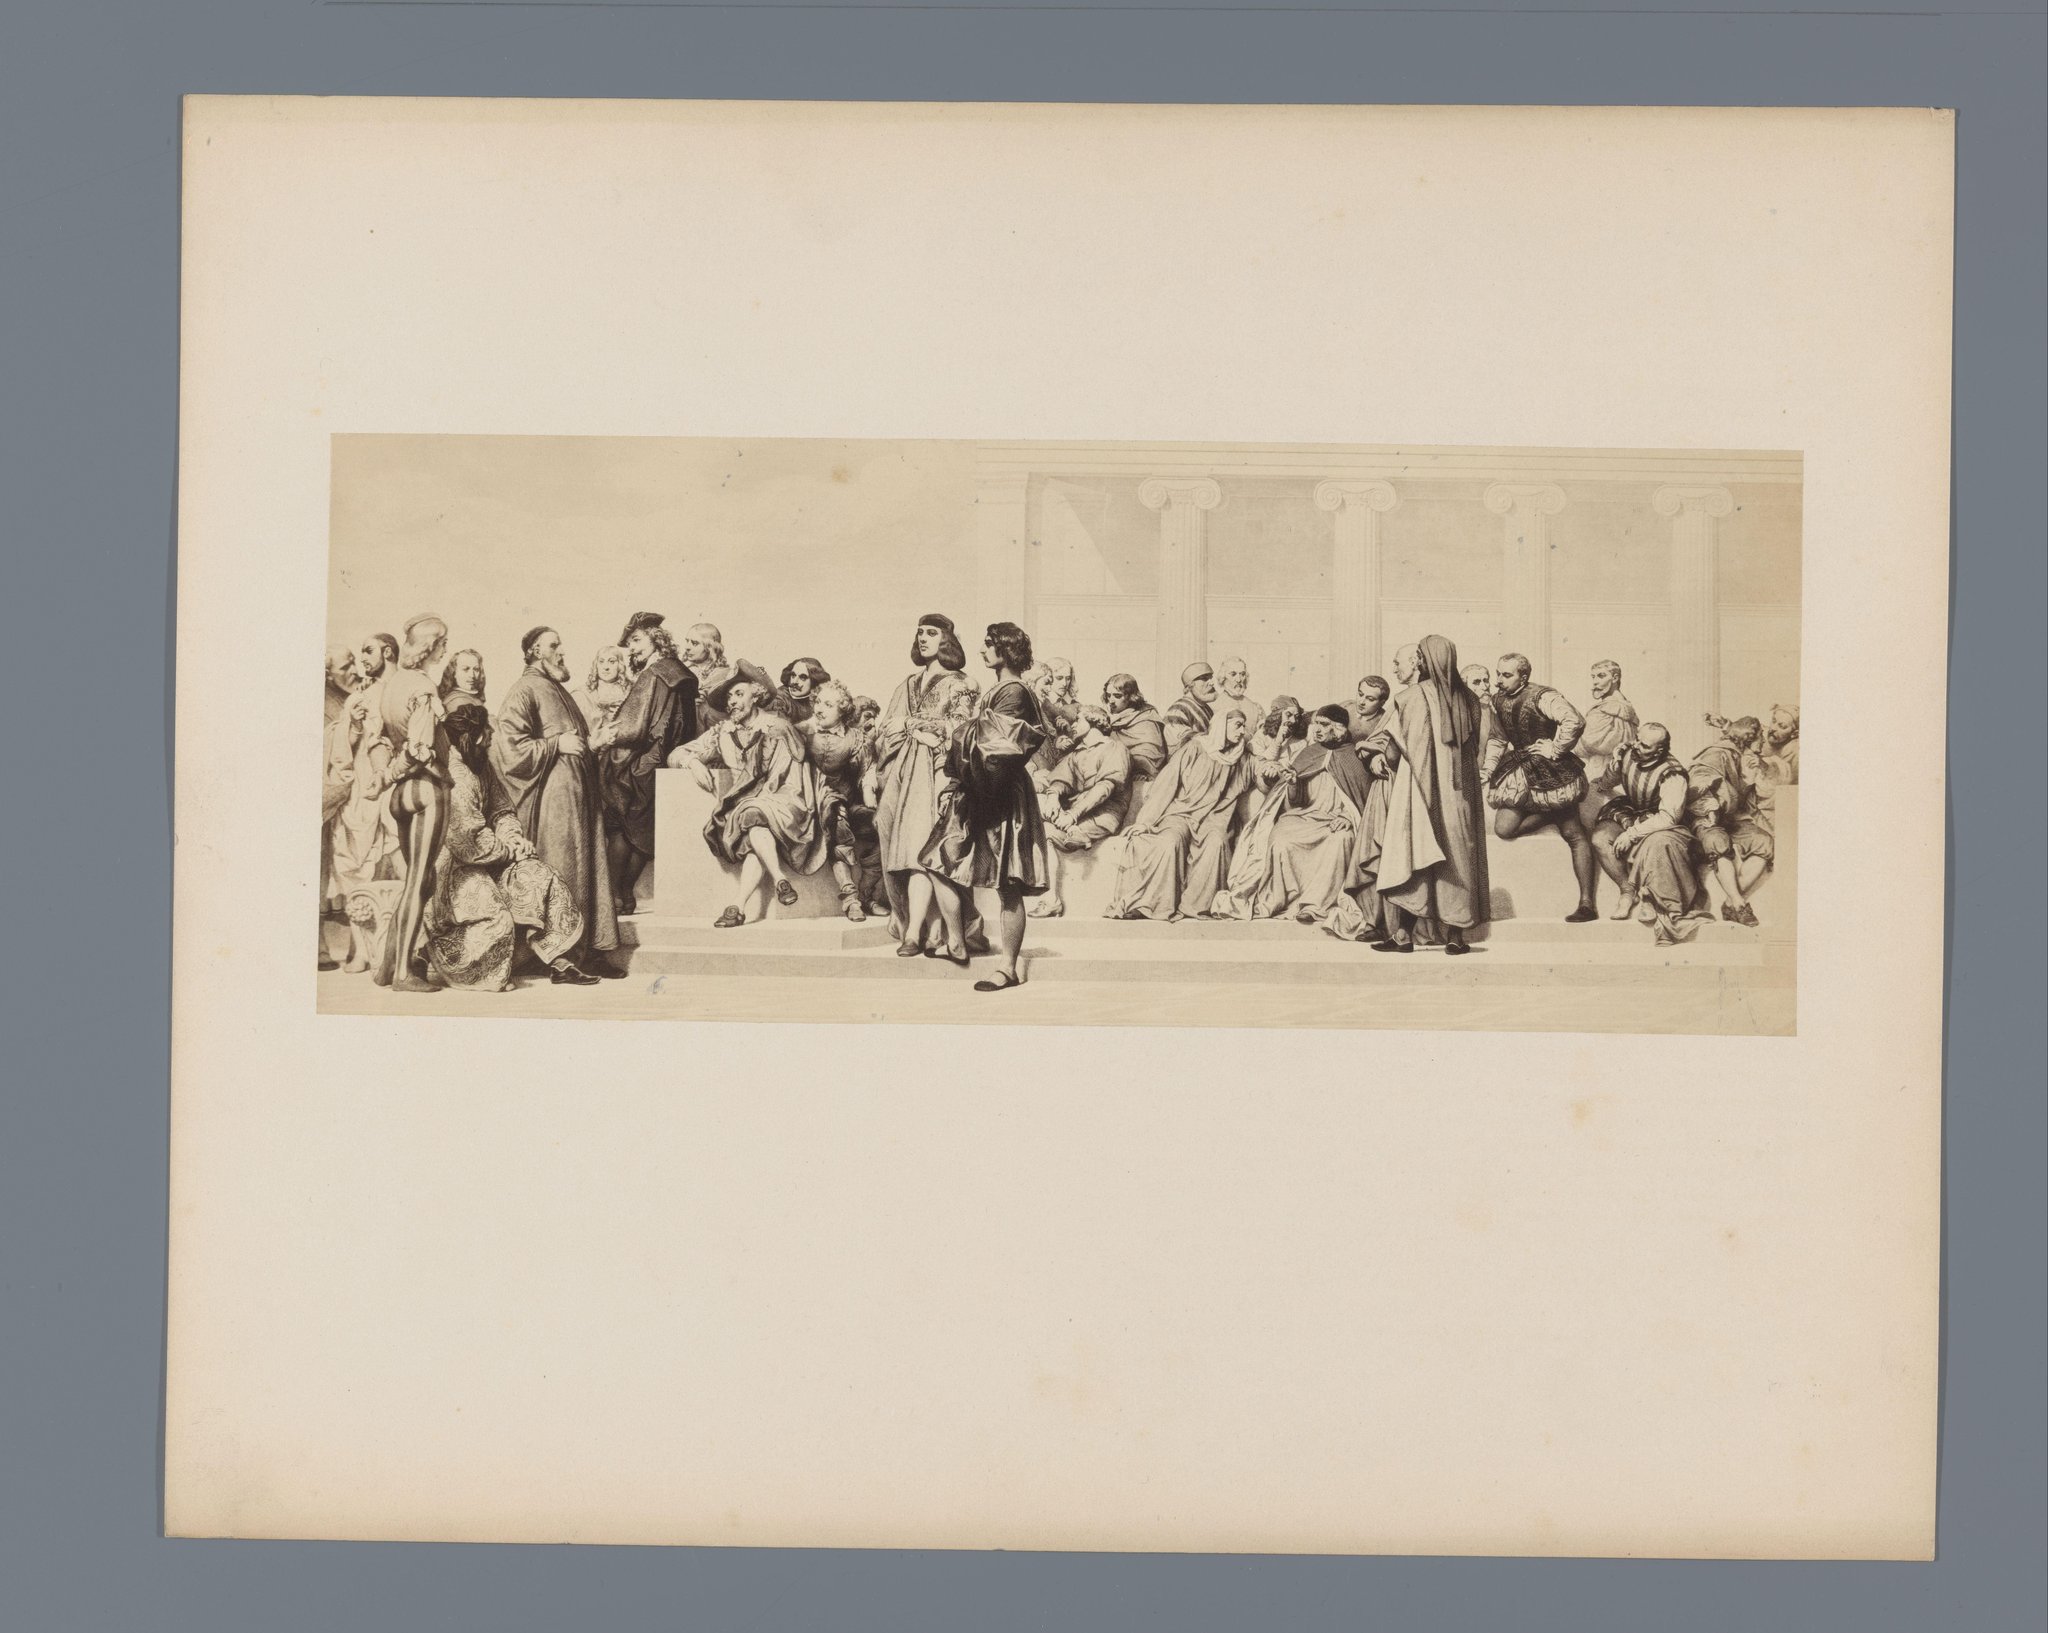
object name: photograph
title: Fotoreproductie van een gravure van een portret van verschillende schilders en beeldhouwers, waaronder Jan van Eyck, Titiaan en Anthony van Dyck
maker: gustav schauer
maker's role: painter, publisher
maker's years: 1826-1902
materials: photographic support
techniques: albumen print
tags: bruges, draughtsman, jan van eyck, venice, titiaan, antwerp, london, painter, print maker, anthony van dyck, portrait, self-portrait of sculptor, portrait, self-portrait of painter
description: Deze foto maakt deel uit van een omslag met drie foto's op drie bladen en een tekstblad.